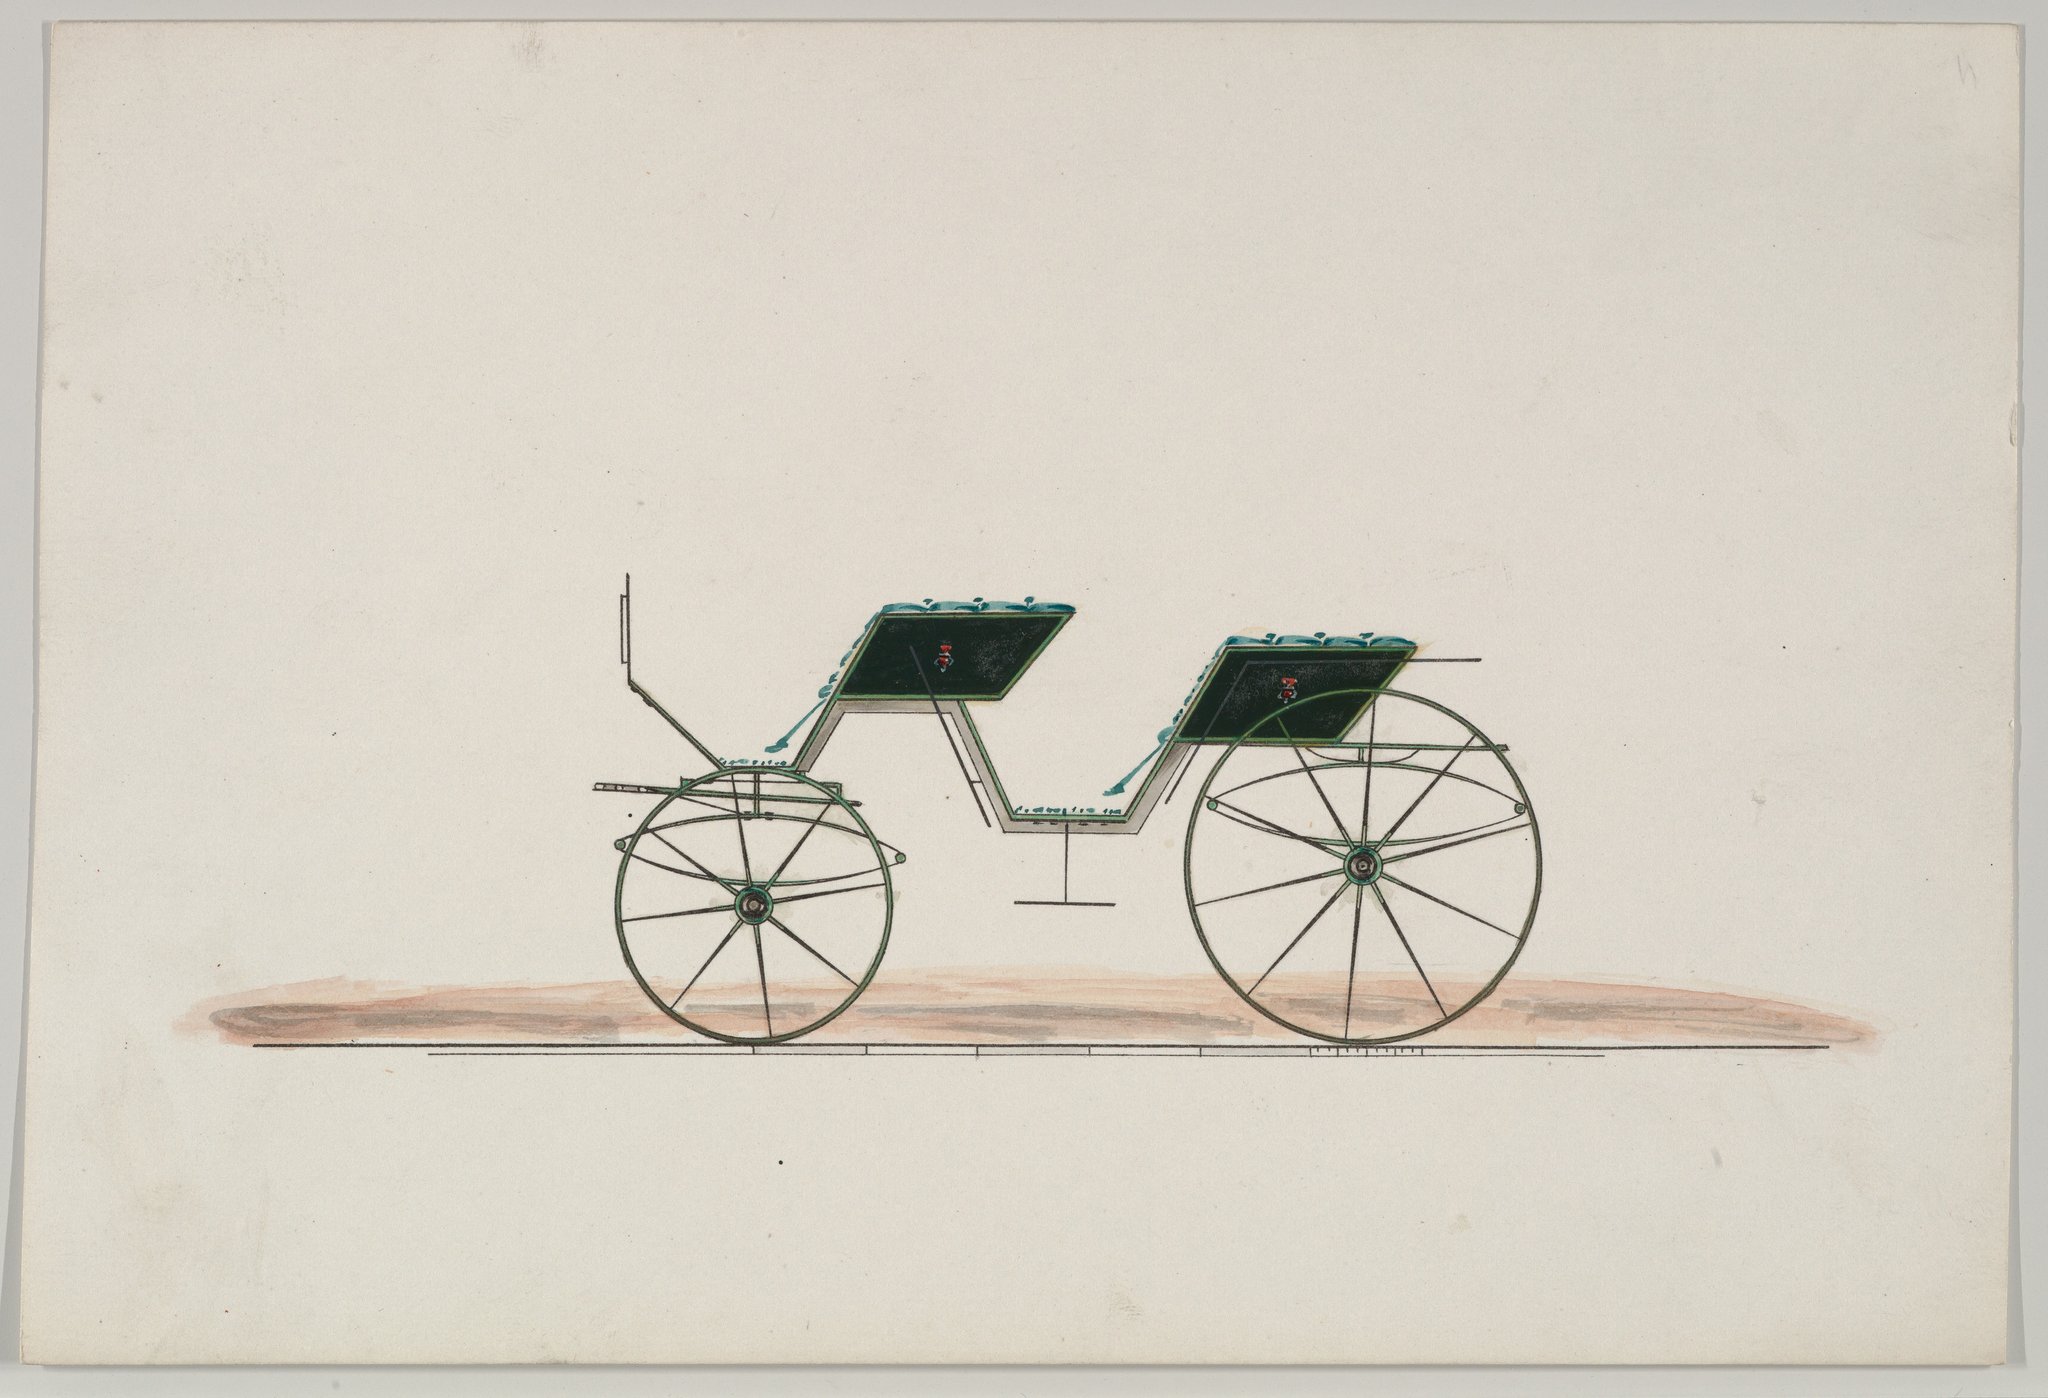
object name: drawing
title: Phaeton, no top (unnumbered)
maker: brewster & co.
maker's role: manufacturer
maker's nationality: american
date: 1850-1870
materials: gouache, gum arabic, ink, watercolor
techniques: pen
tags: carriages